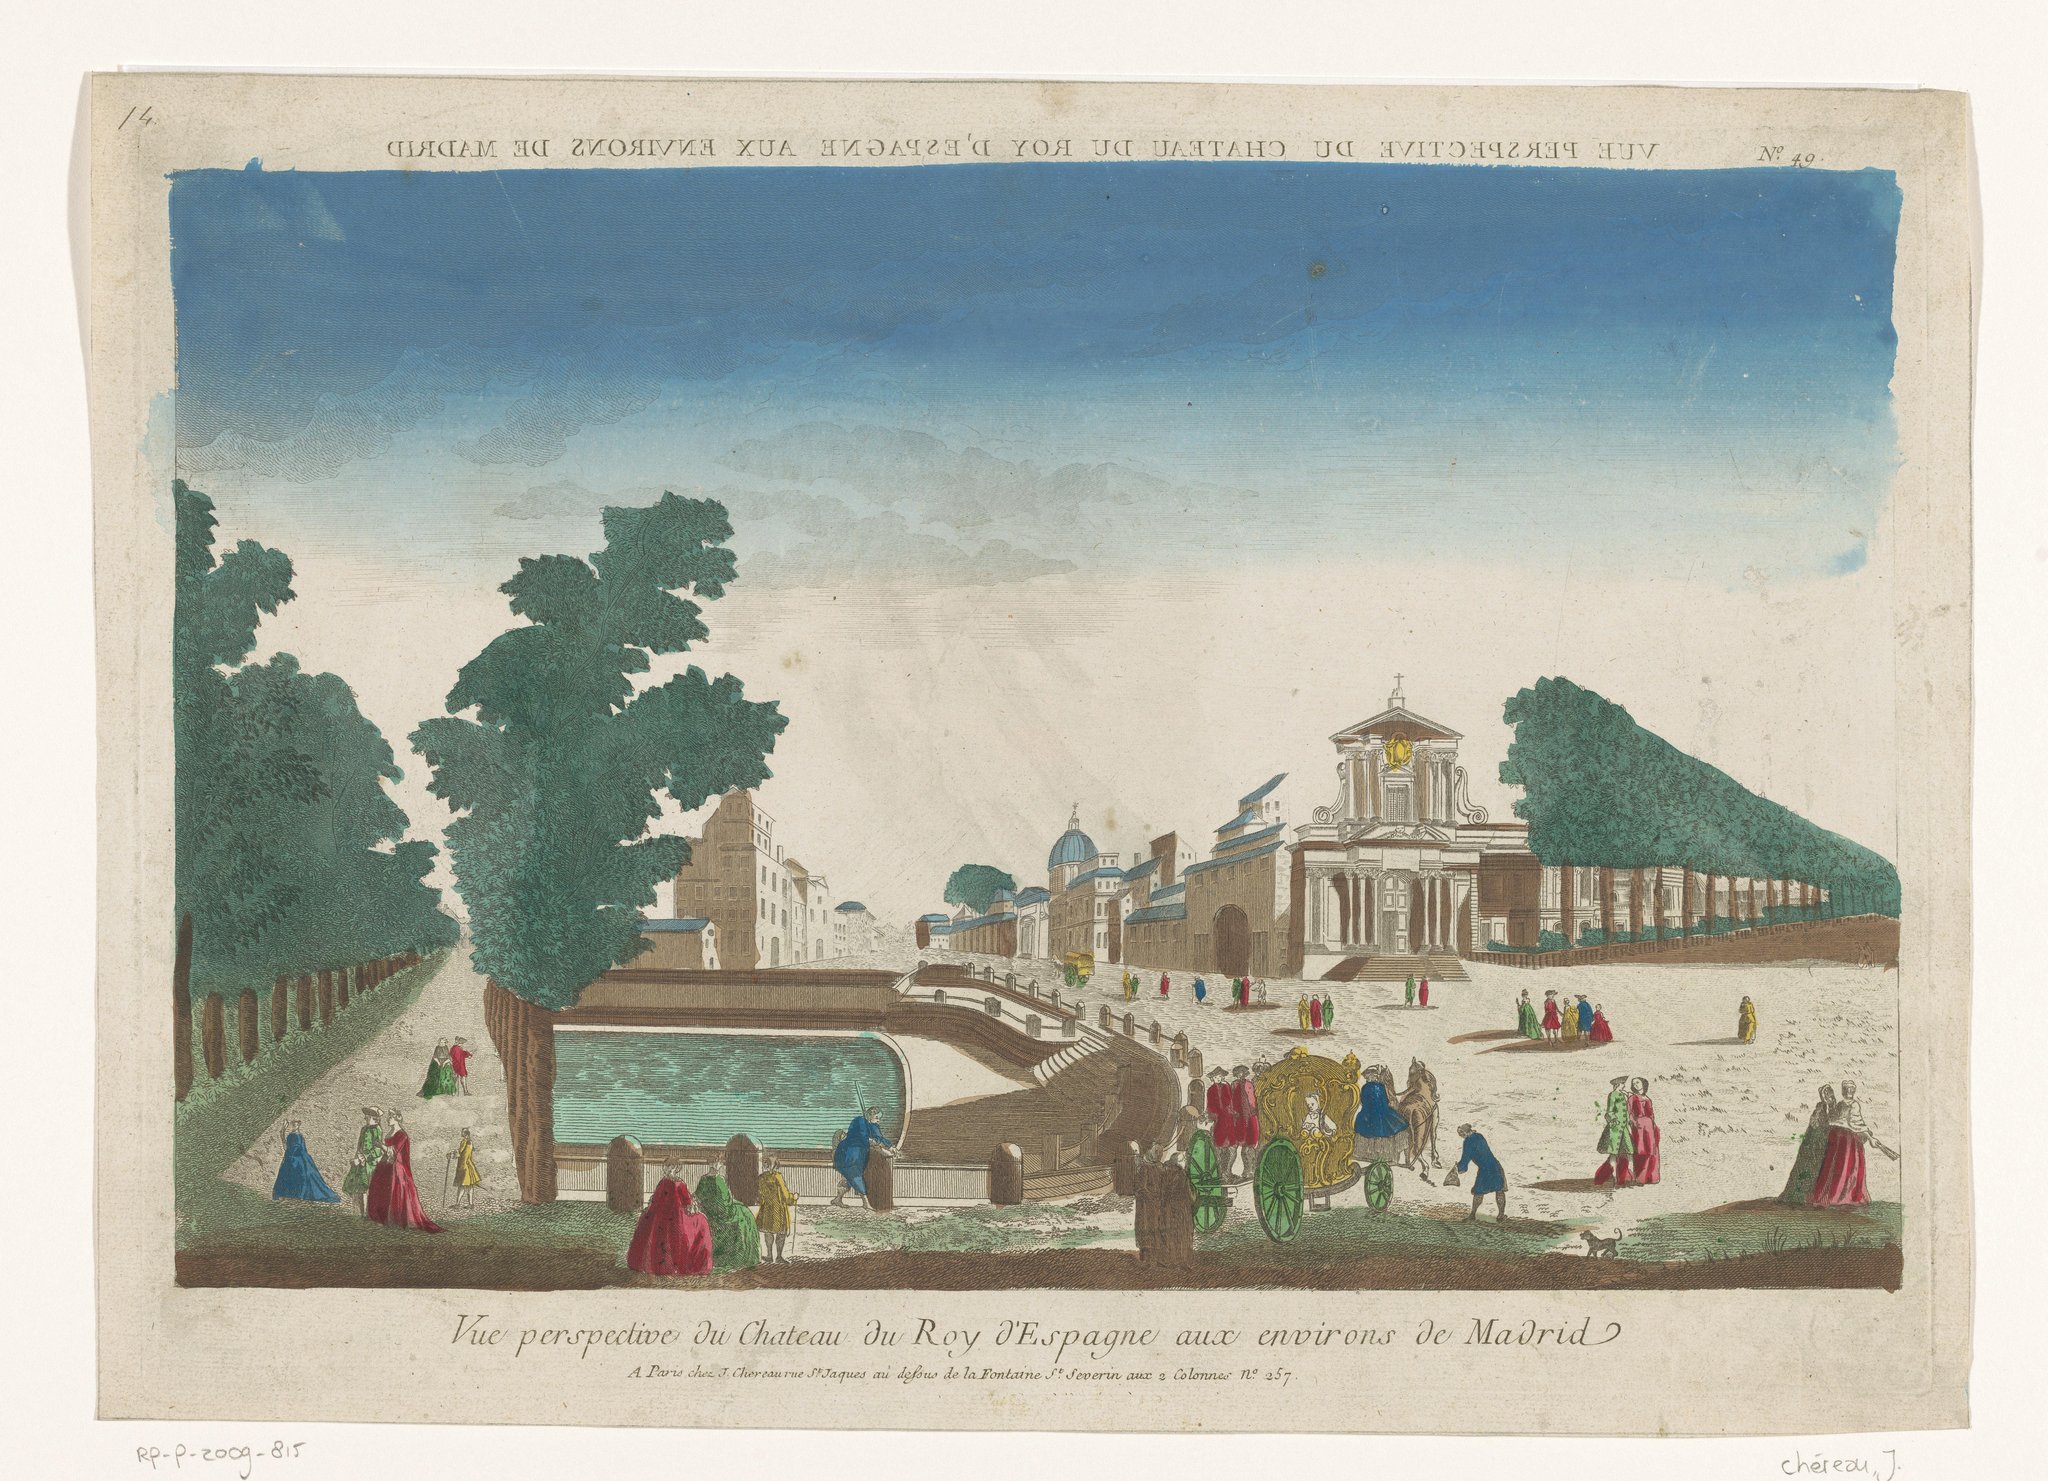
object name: print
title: Vue perspective du chateau du roy d'Espagne aux environs de Madrid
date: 1700-1799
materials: paper, watercolor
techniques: brush, etching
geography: france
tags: madrid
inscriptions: collector's mark: Lugt 2228, watermark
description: In het midden een weg langs een reeks gebouwen, links en rechts met bomen omzoomde lanen en op de voorgrond een vijver met een trap. Overal wandelaars en koetsen.